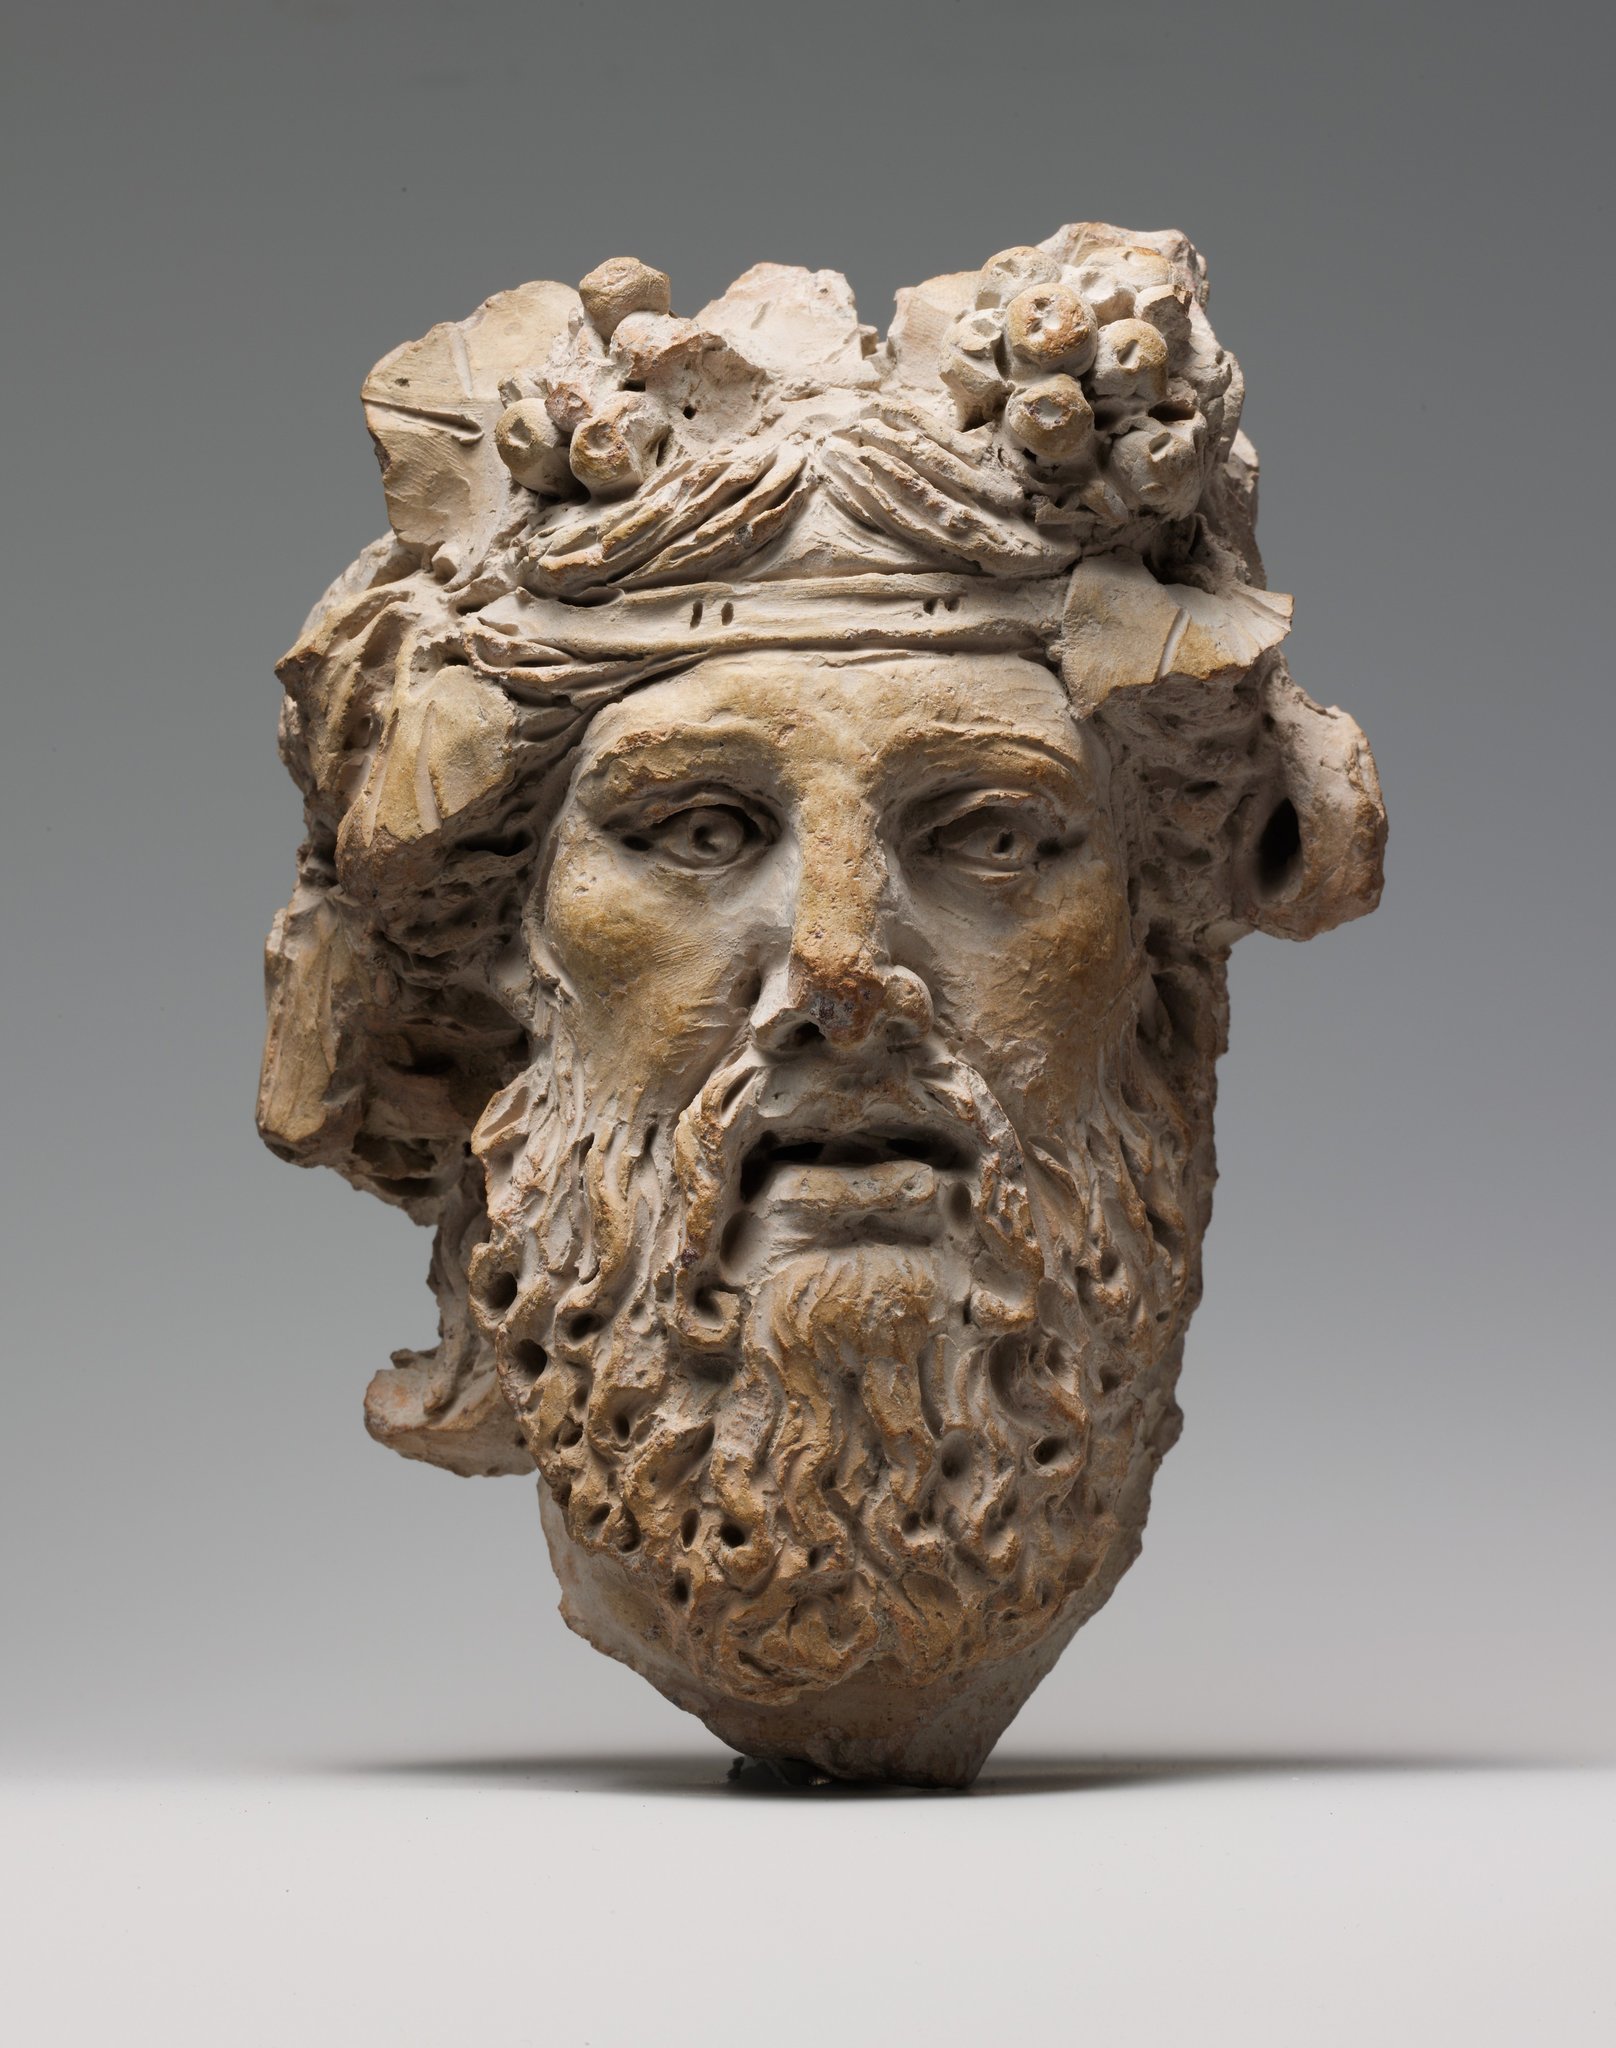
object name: head of dionysos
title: Terracotta head of Dionysos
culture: greek or roman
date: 100-1 BCE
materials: terracotta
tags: heads,dionysus